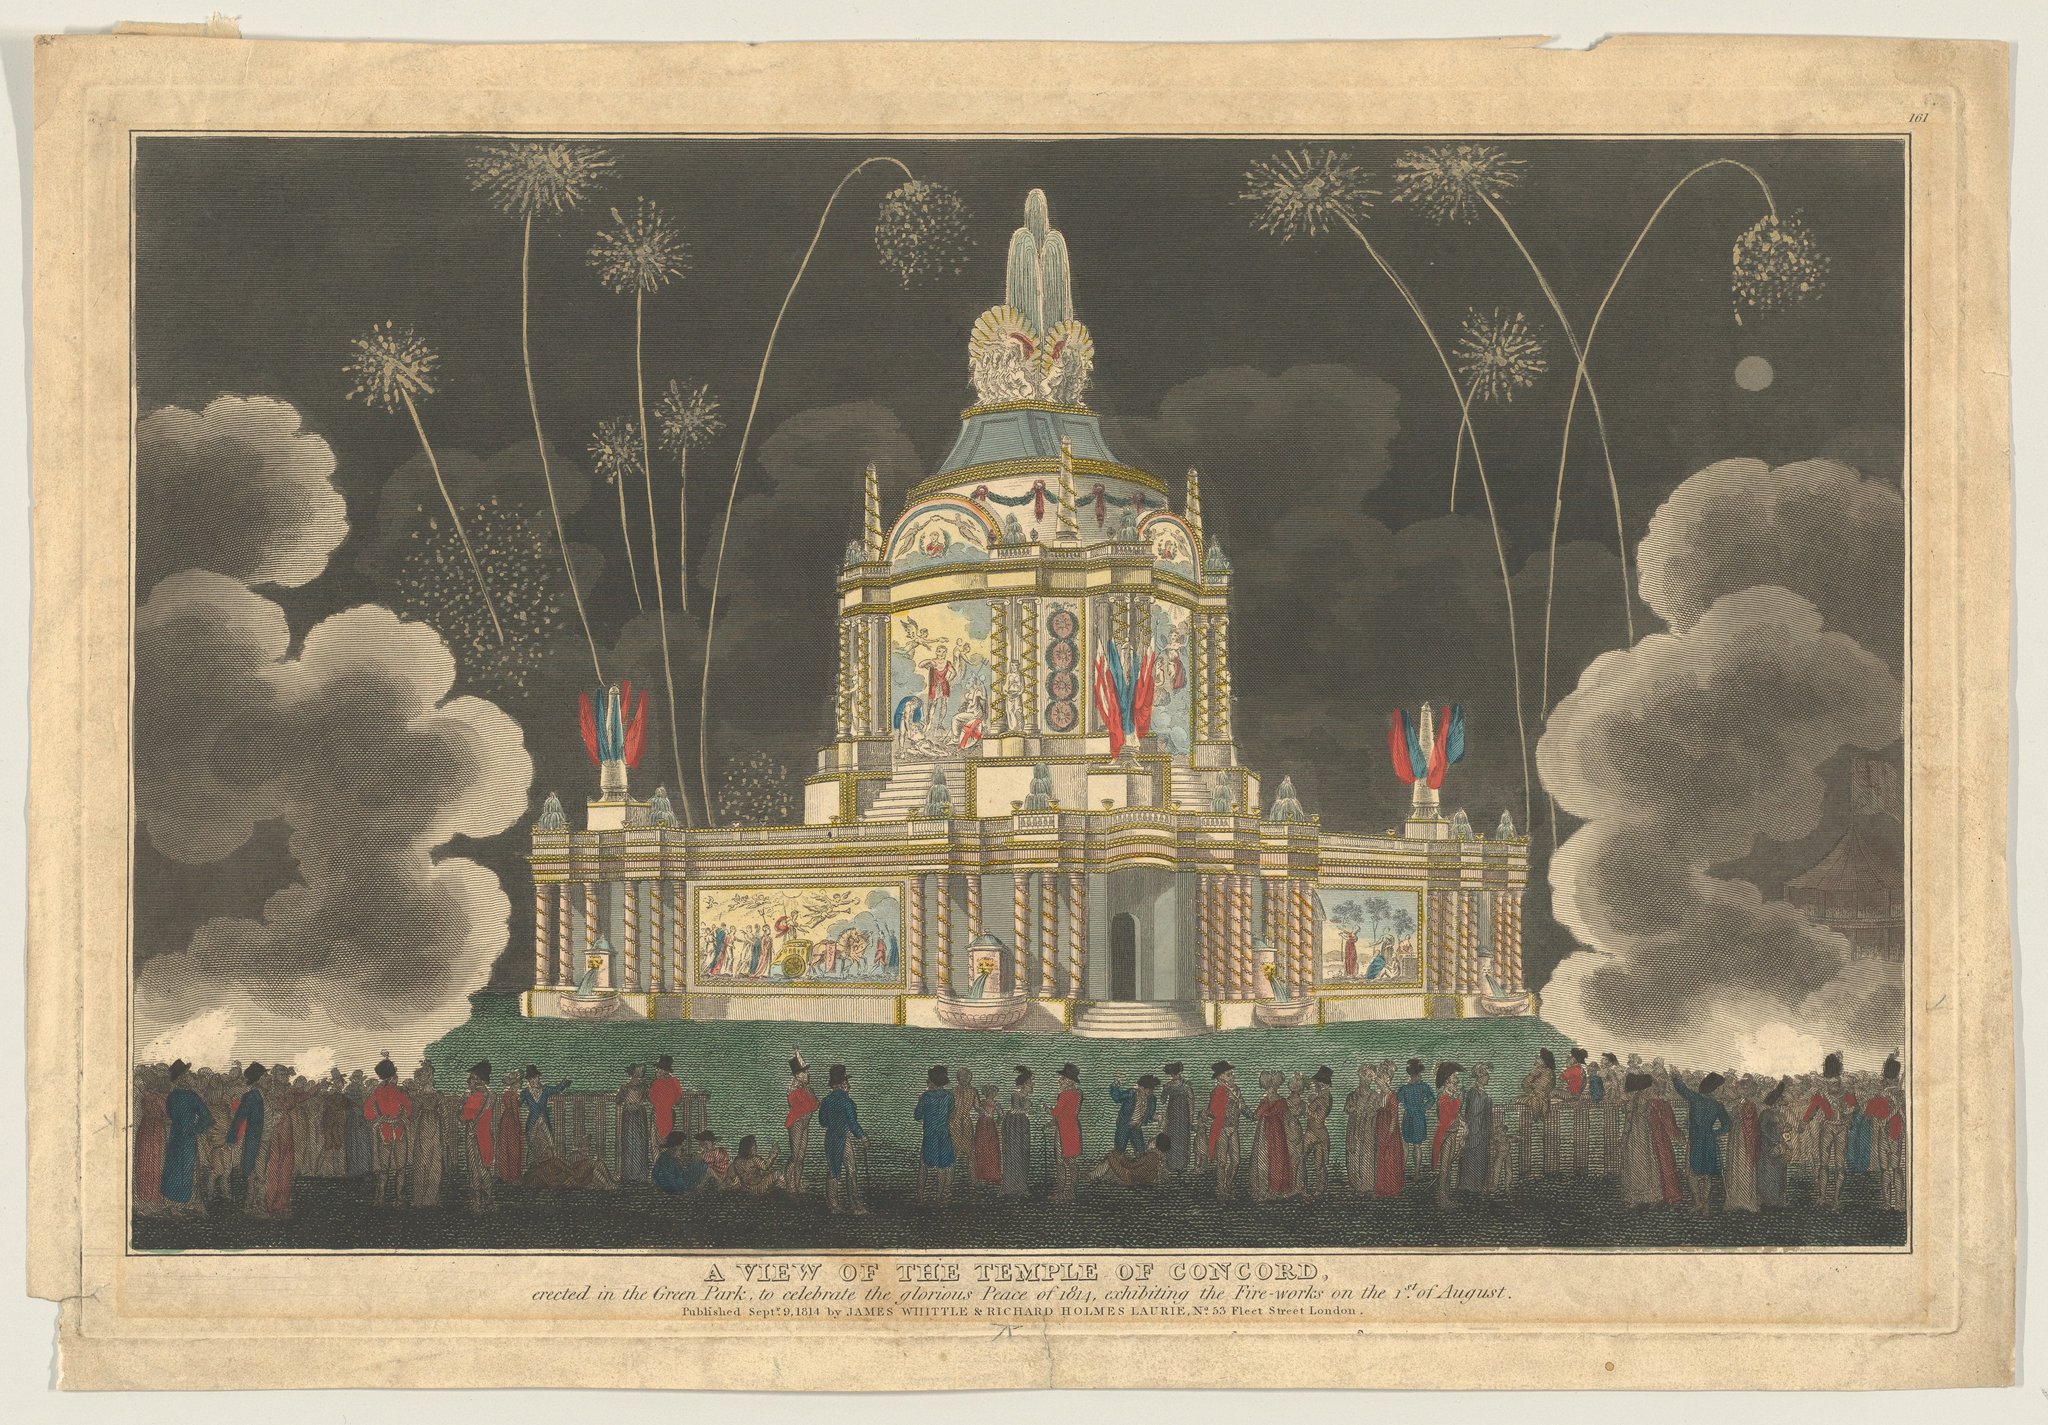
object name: print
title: A View of the Temple of Concord Erected in the Green Park, to Celebrate the Glorious Peace of 1814, Exhibiting the Fireworks on the 1st of August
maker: robert laurie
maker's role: publisher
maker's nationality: british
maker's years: 1755-1836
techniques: engraving, etching, hand coloring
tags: fireworks